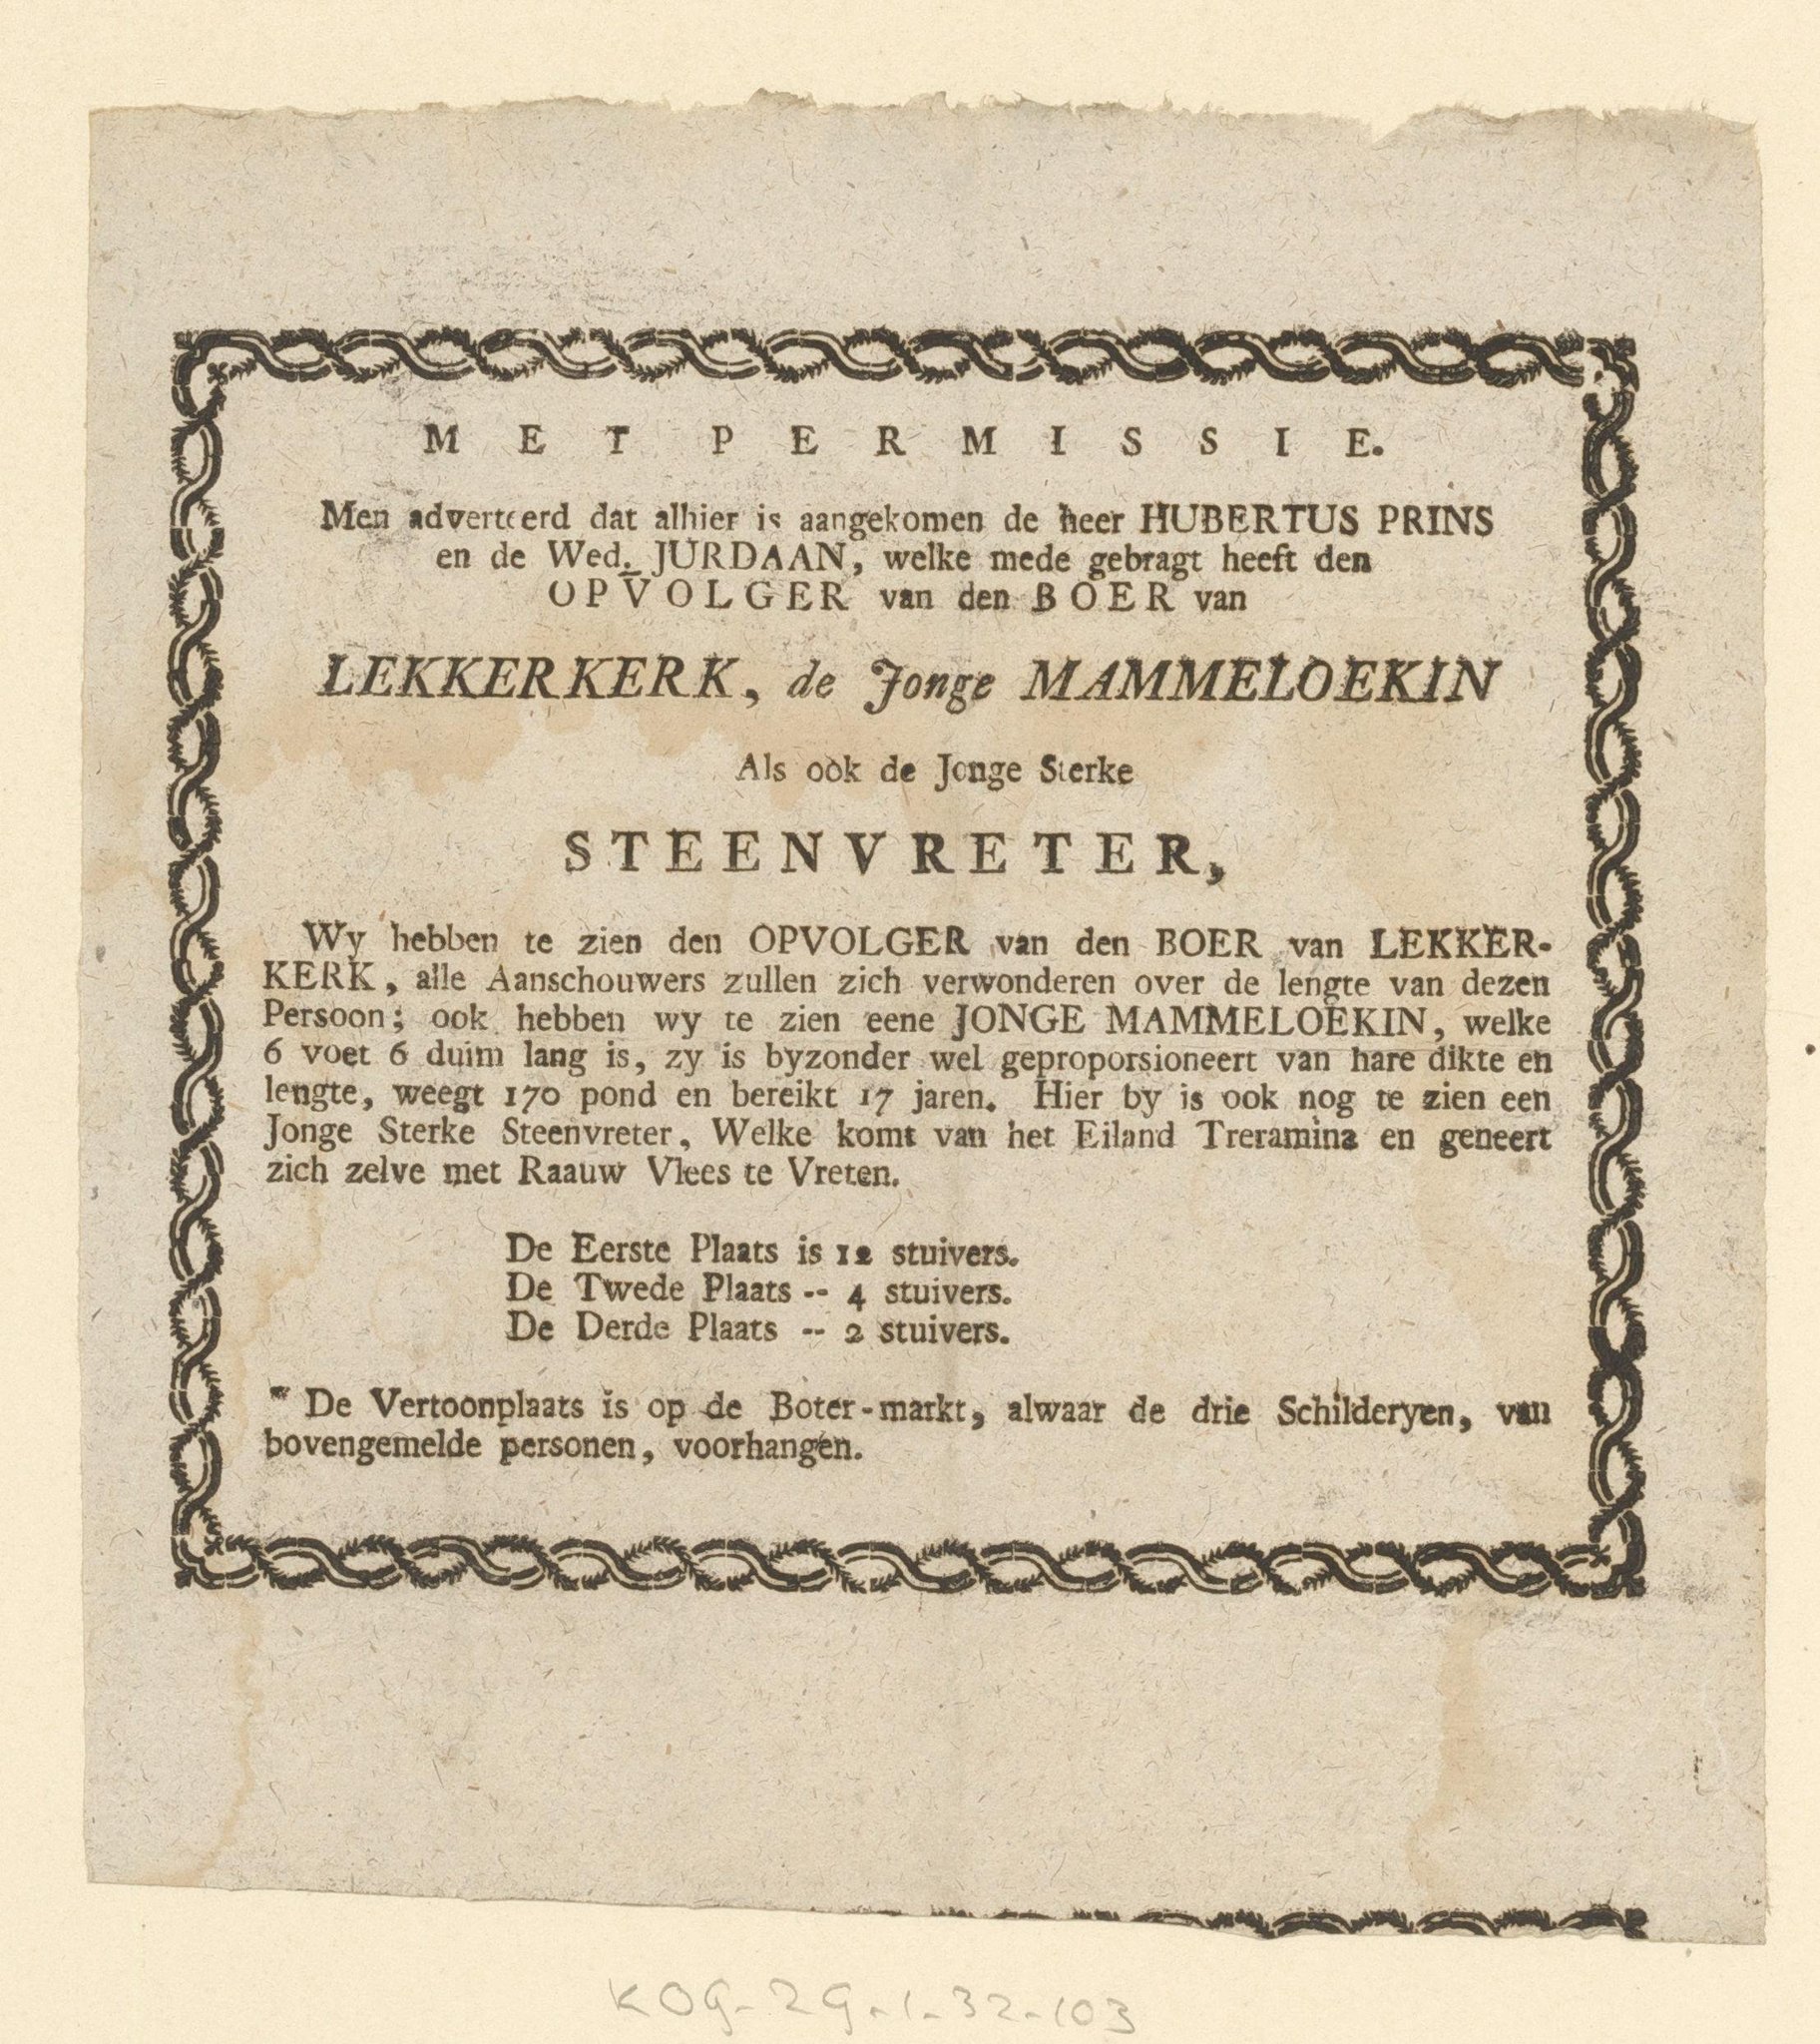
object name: text sheet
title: Hubertus Prins en de Wed. Jurdaan, welke mede gebragt heeft den opvolger van den Boer van Lekkerkerk, de Jonge Mammeloekin als ook de Jonge Streke Steenvreter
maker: Anonymous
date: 1806-1815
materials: paper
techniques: letterpress printing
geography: amsterdam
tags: pleasure fair and circus, human monstrosities ~ freak show, amsterdam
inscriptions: collector's mark: Lugt 1641, collector's mark